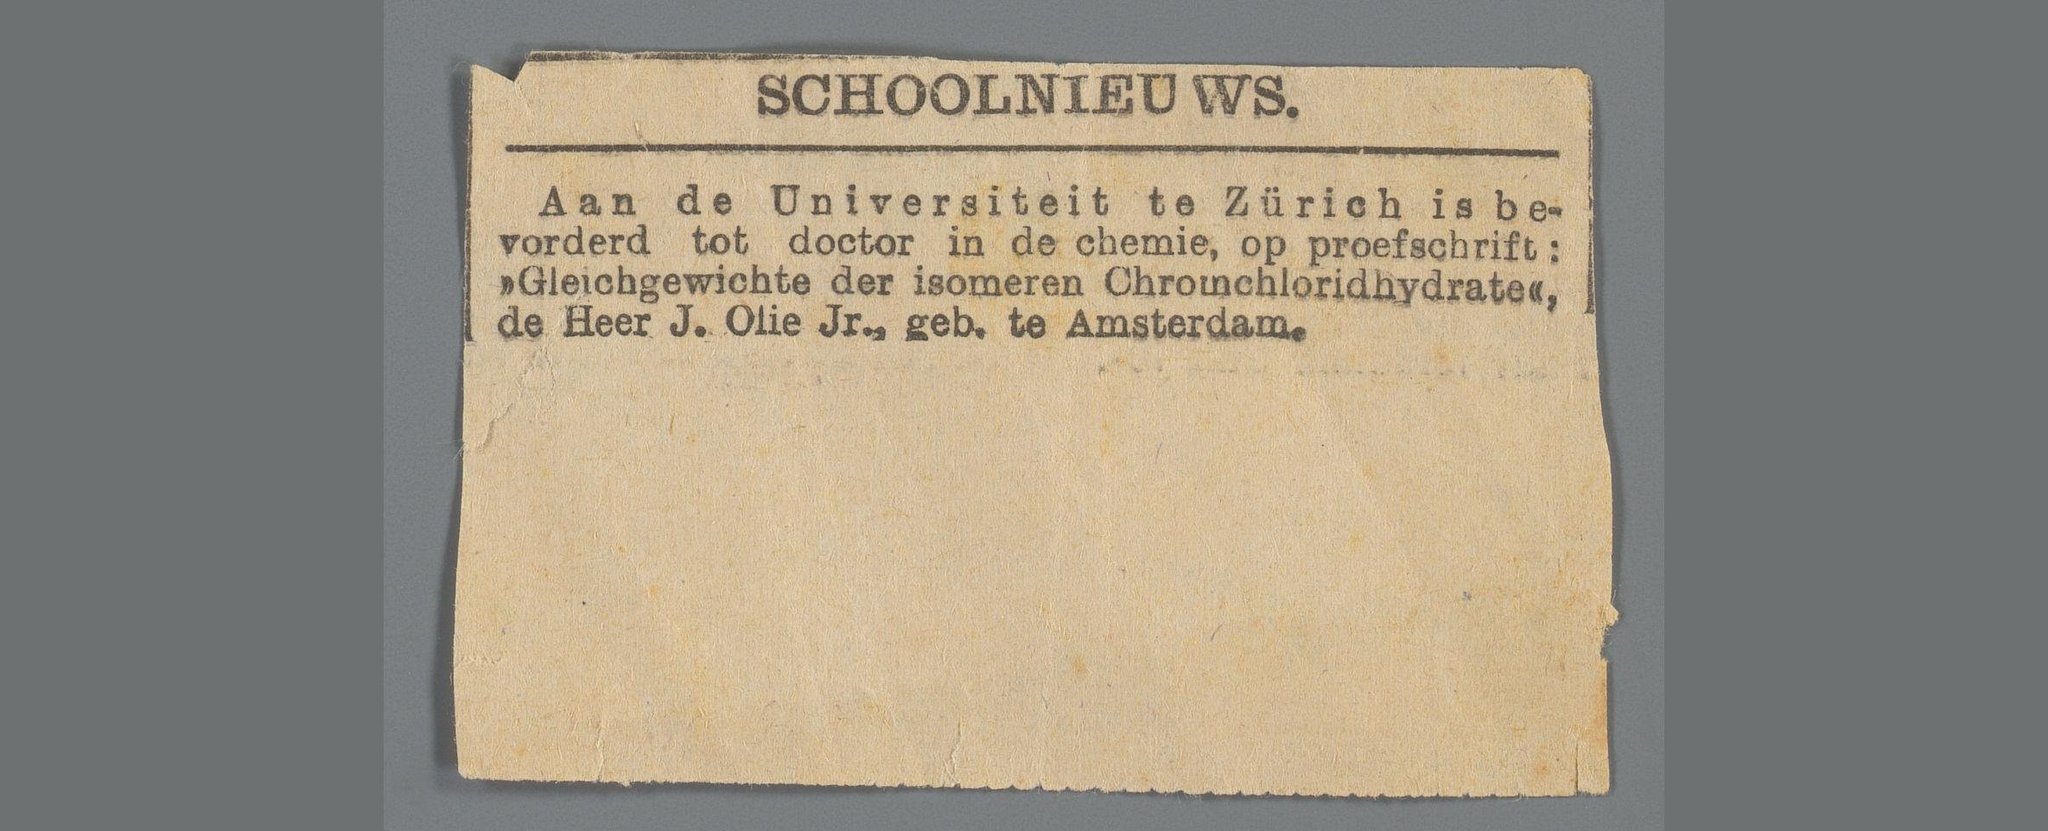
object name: newspaper clipping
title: Schoolnieuws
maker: Anonymous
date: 1907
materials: paper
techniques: letterpress printing